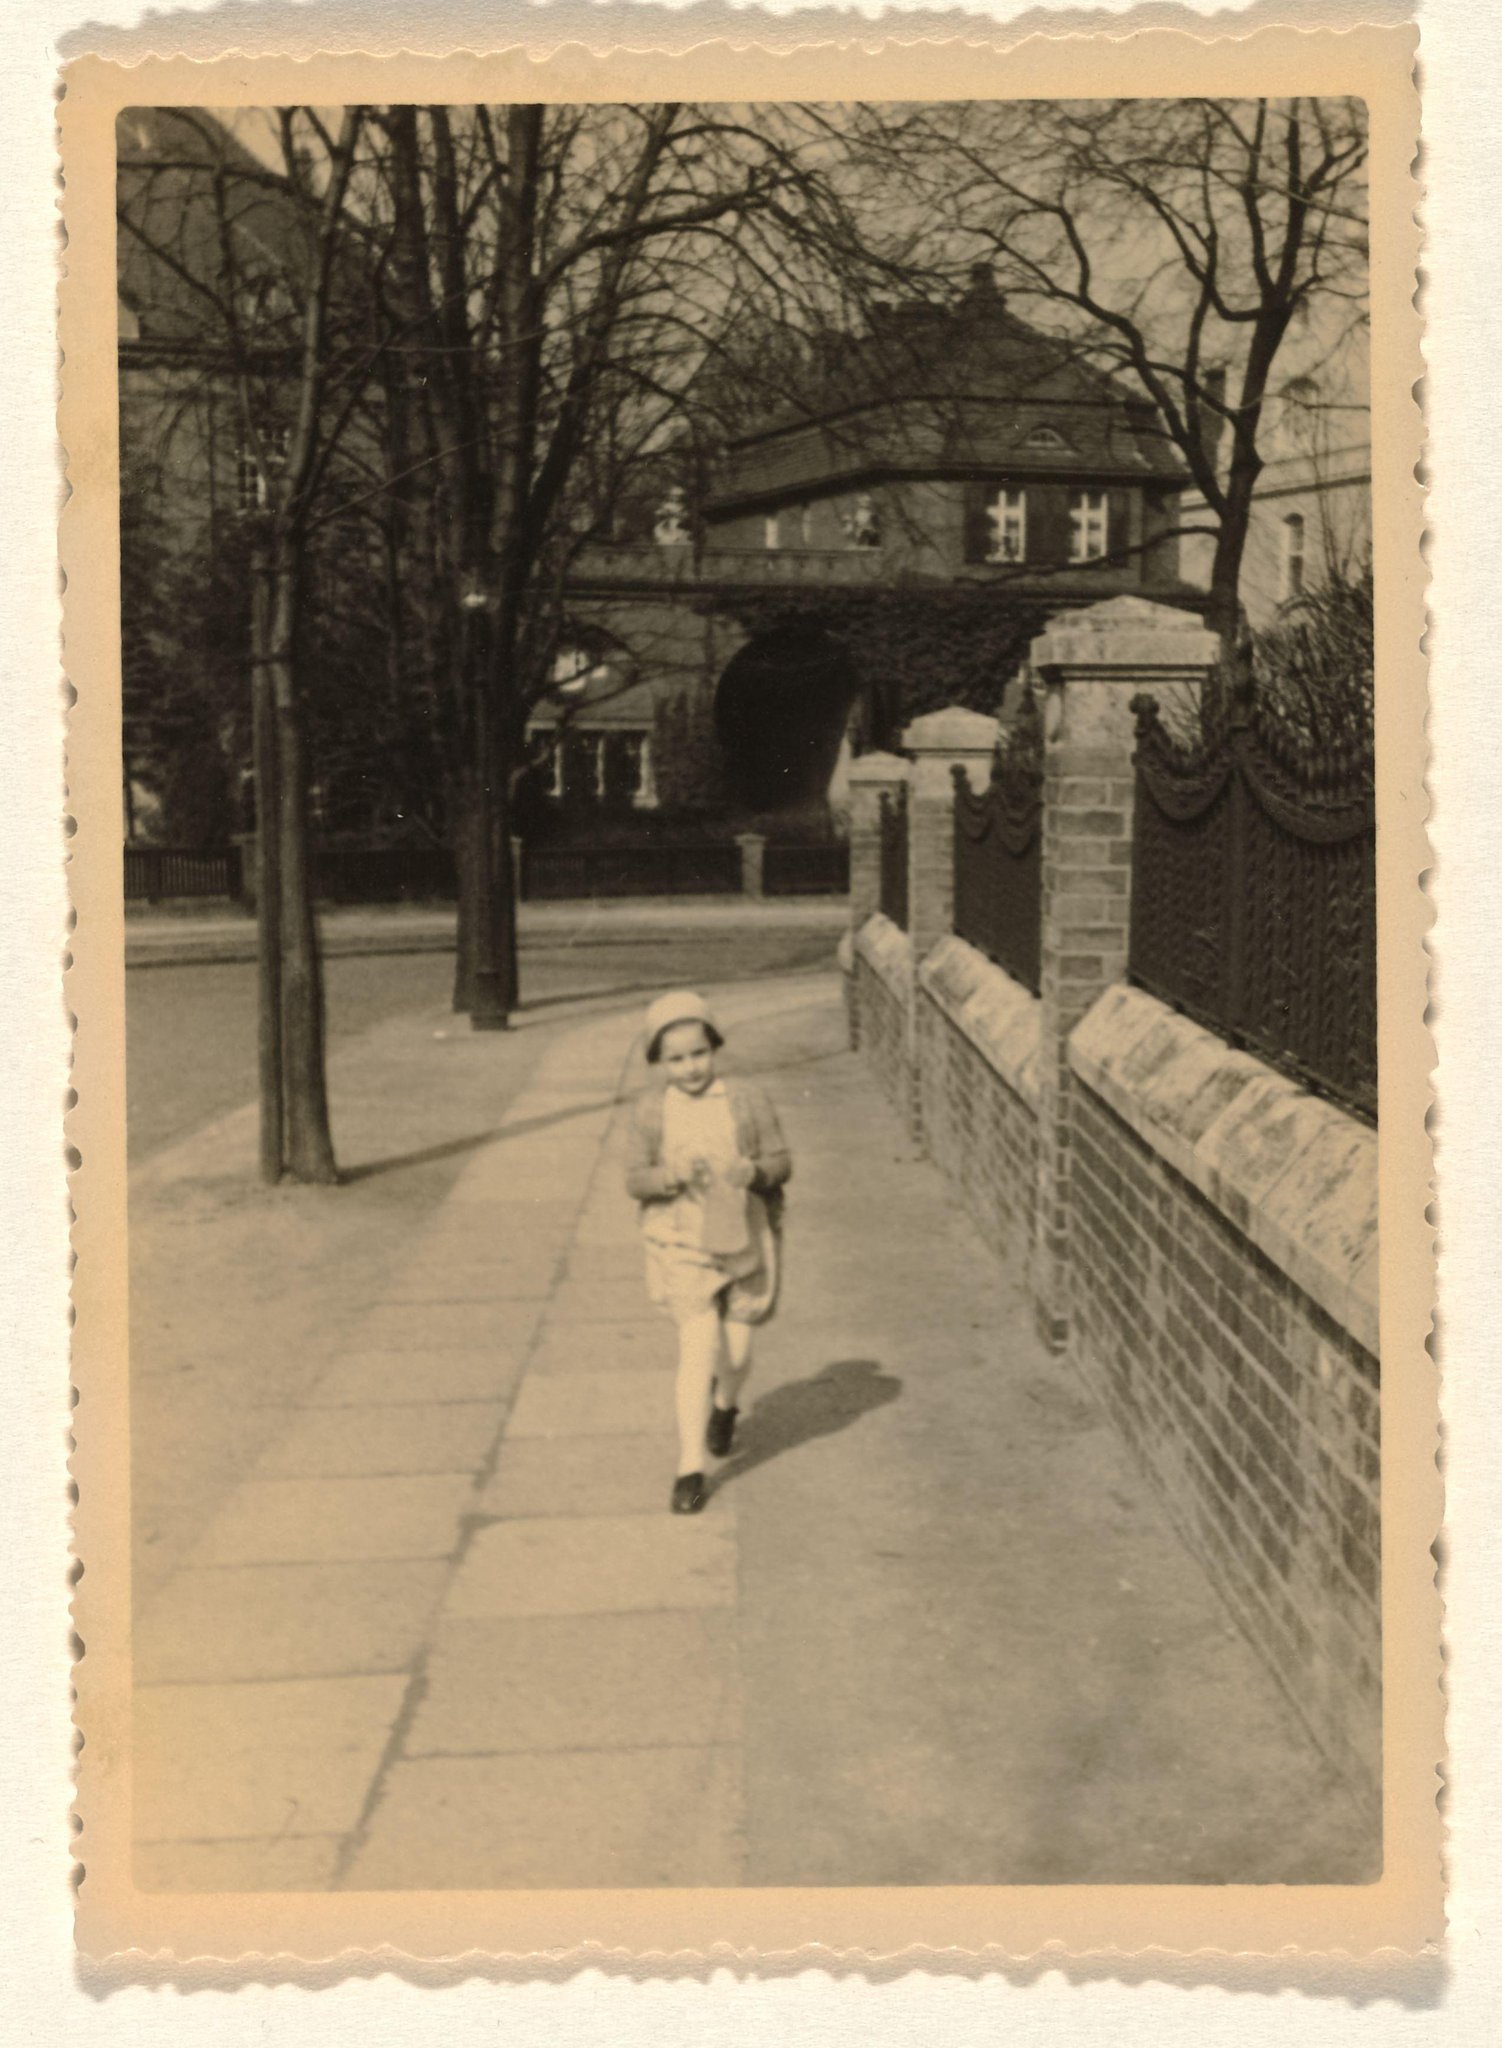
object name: photograph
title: Isabel Wachenheimer in Hamburg, 1935 bij het huis van haar oom Willy Moos, Bellevue 62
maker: Anonymous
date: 1935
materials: photographic support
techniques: gelatin silver print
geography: hamburg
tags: leiden, isabel wachenheimer-elon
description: Dit object is onderdeel van de nalatenschap van Isabel Elon-Wachenheimer (1928-2010). Tot haar overlijden behoorde het samen met de andere objecten uit de nalatenschap tot haar privédomein van Isabel Wachenheimer. In die particuliere context zijn deze objecten tezamen en individueel aandenkens - aan de jeugd, ouders en familie van Isabel Wachenheimer vóór en tijdens de Shoah en aan haar leven na de Tweede Wereldoorlog. Isabel Wachenheimer, die van juni 1943 tot mei 1945 gevangen zat in Kamp Westerbork, Theresienstadt, Auschwitz, Lenzing a/d Oberdonau (een buitenkamp van Mauthausen), overleefde de Shoah. Haar ouders – Eugène Wachenheimer en Else Wachenheimer-Moos - werden op 14 oktober 1944 in Auschwitz-Birkenau vermoord.